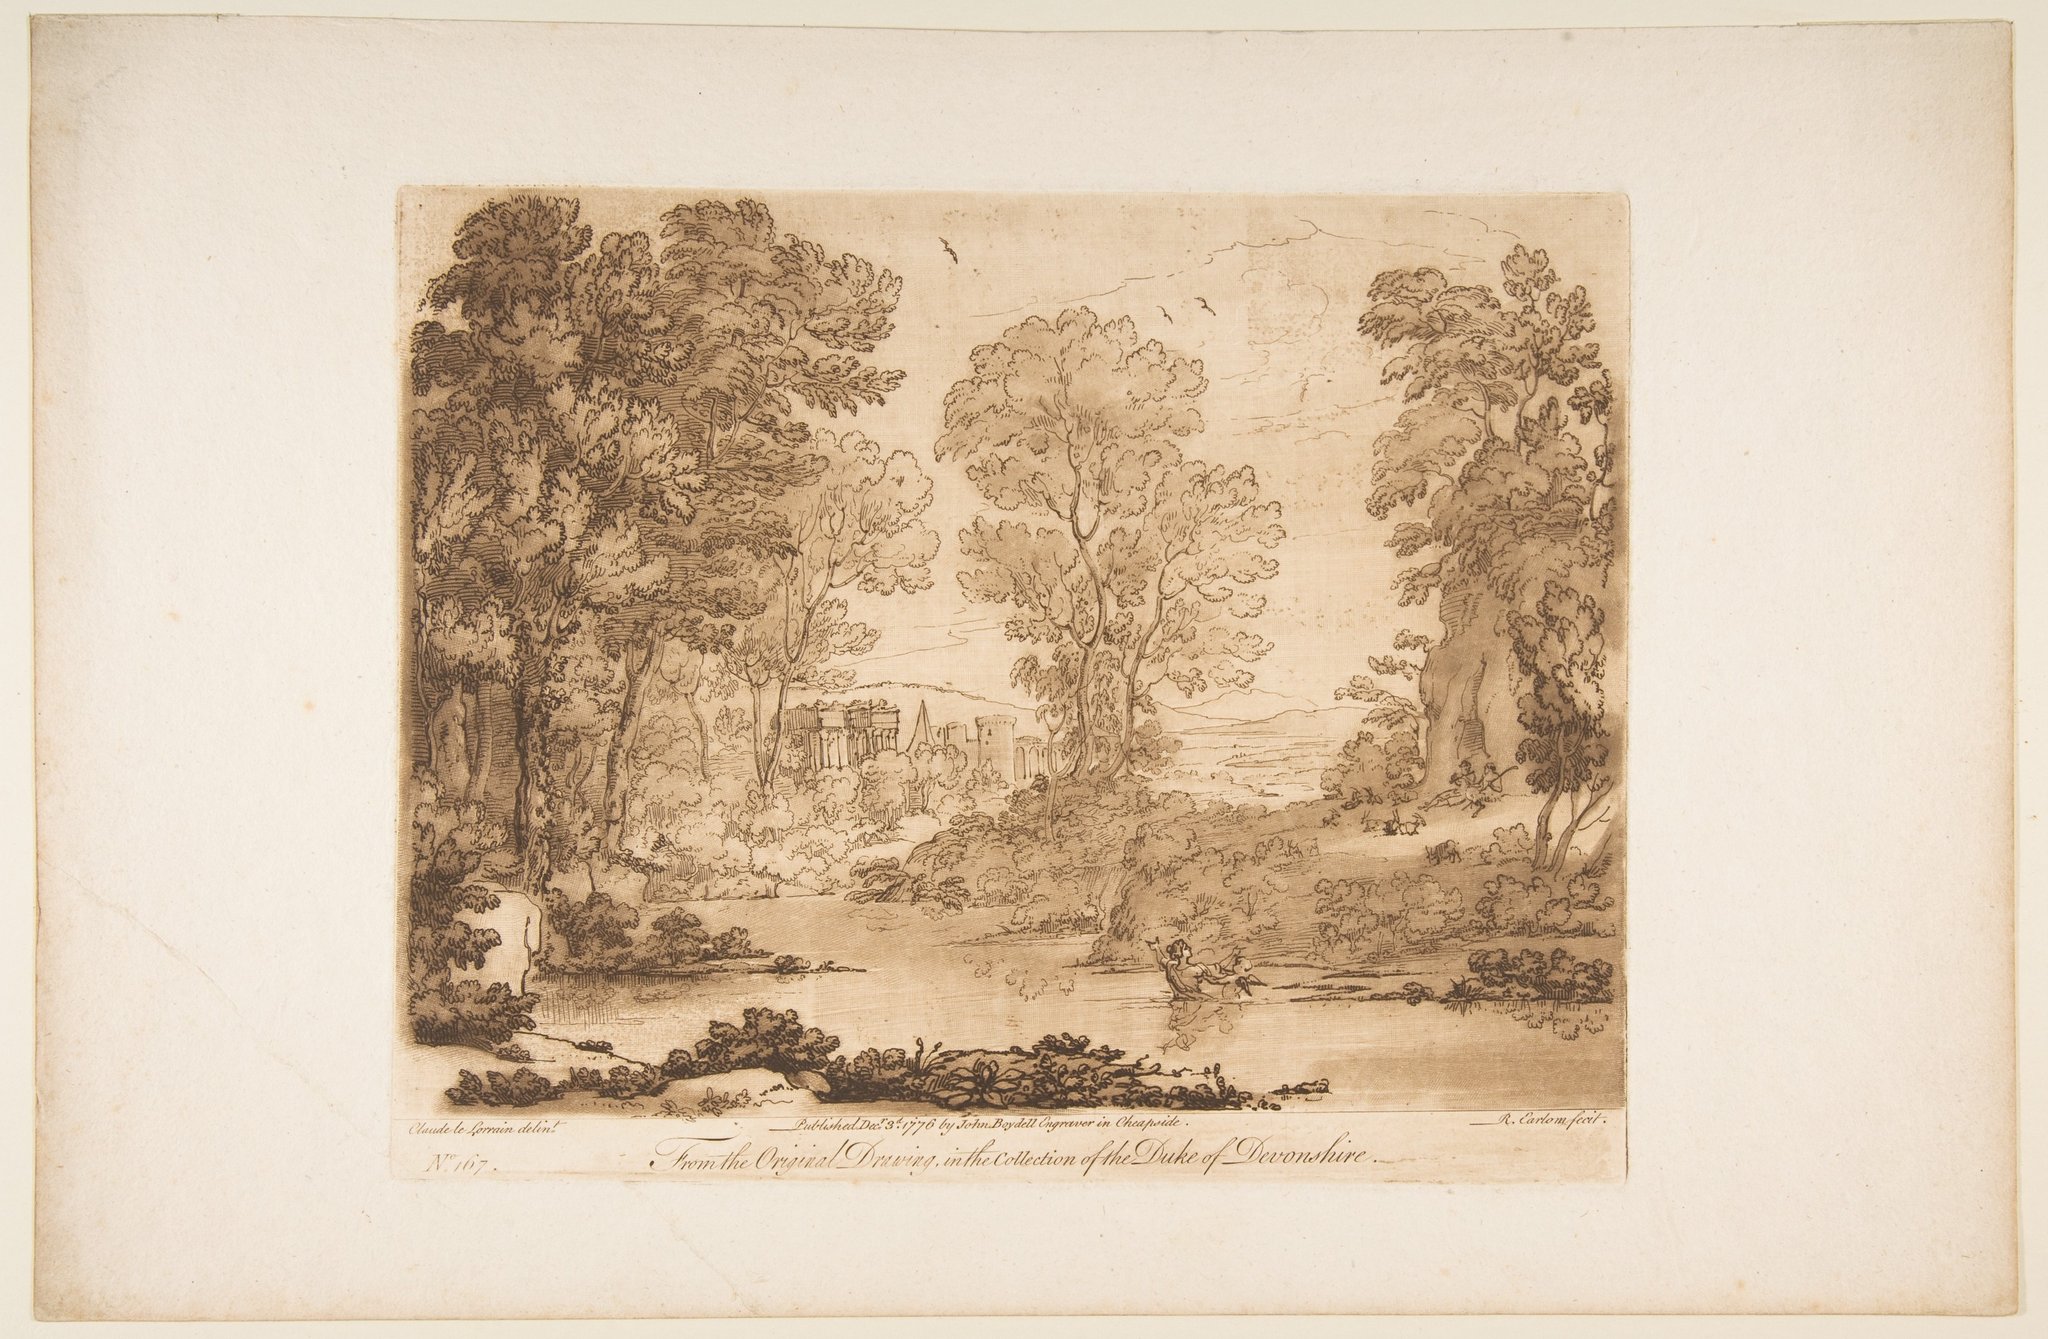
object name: print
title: Landscape with Cupid and Psyche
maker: richard earlom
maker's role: engraver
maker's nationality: british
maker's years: 1743-1822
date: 1776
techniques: etching, mezzotint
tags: cupid,psyche,landscapes